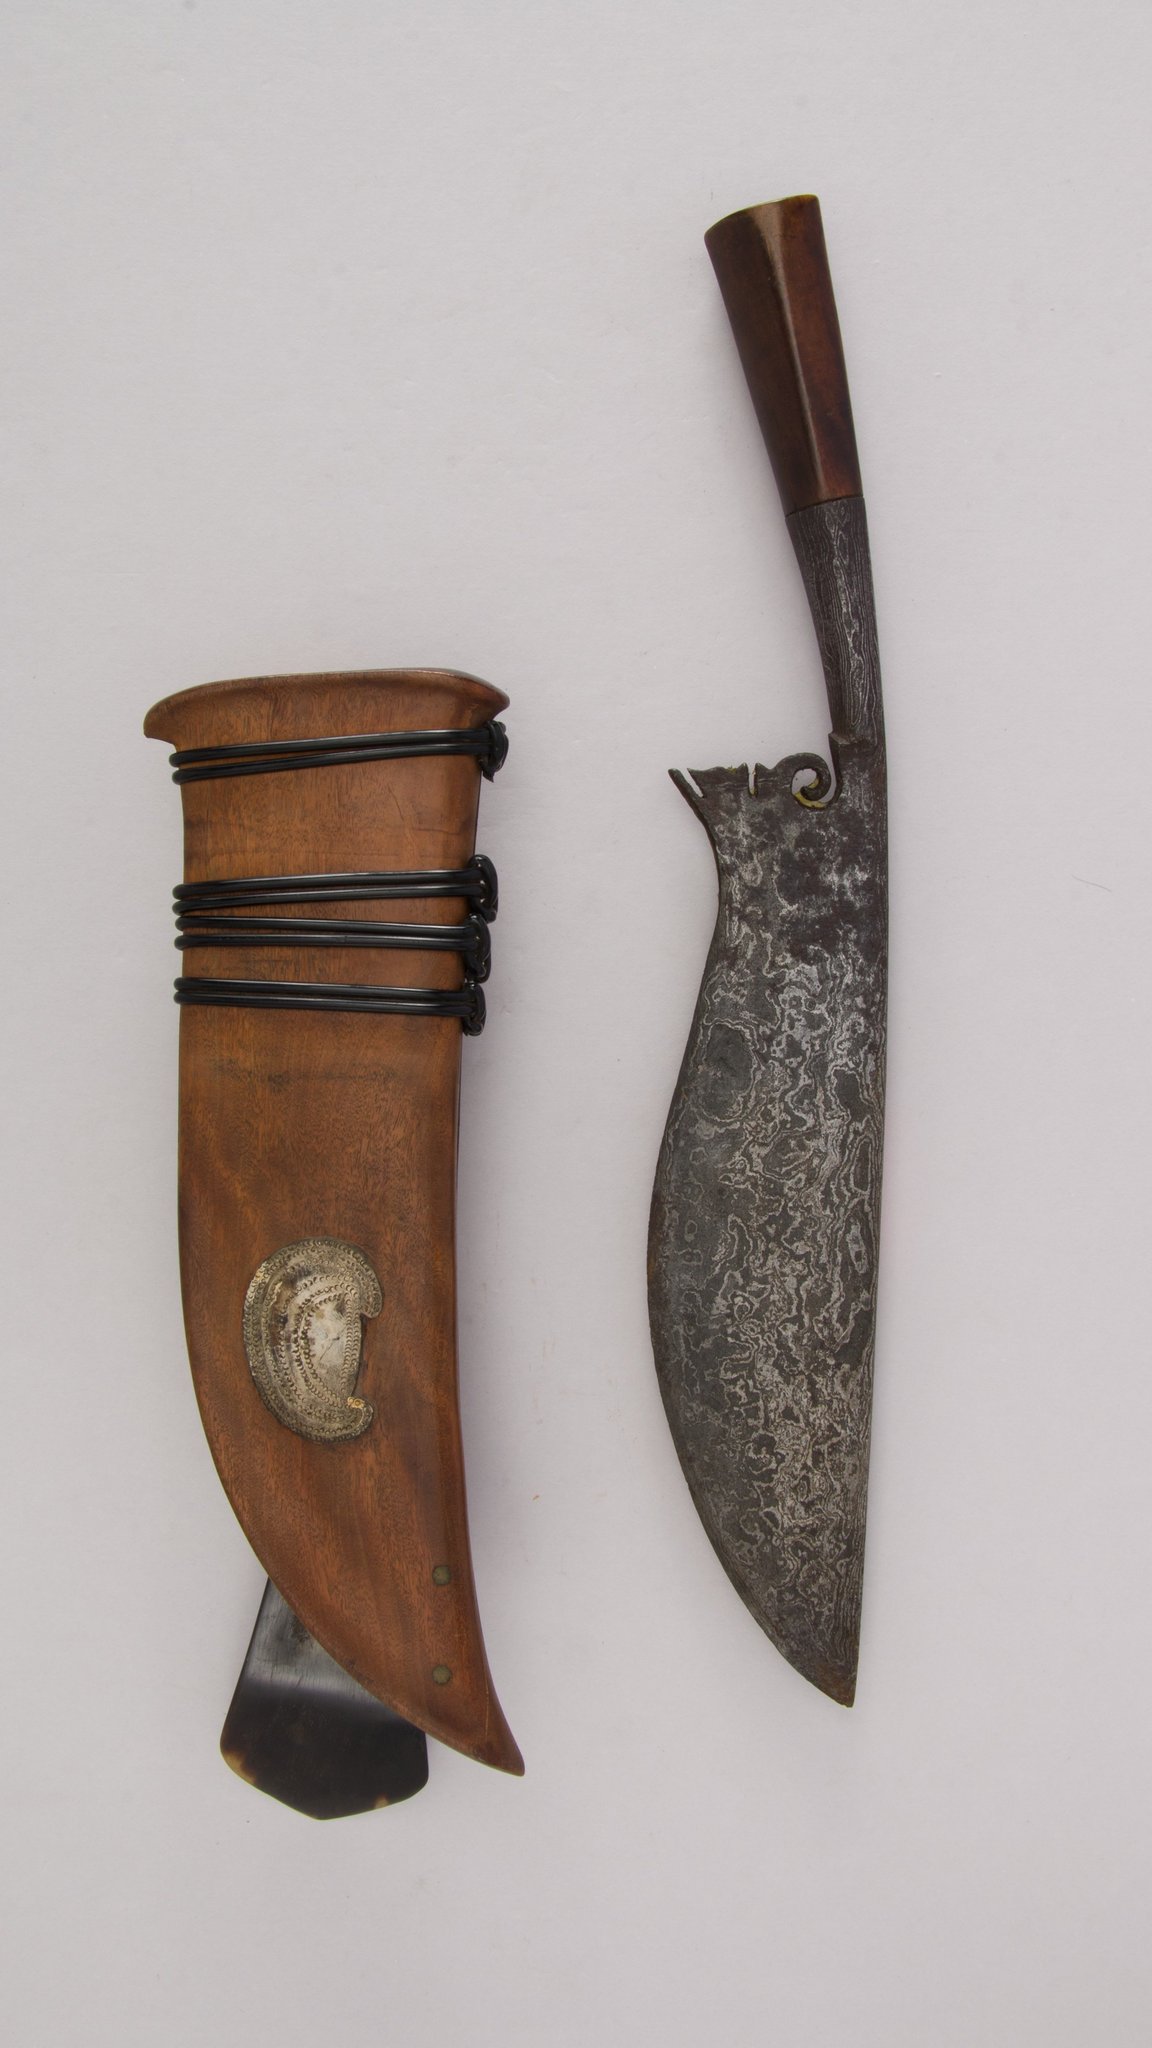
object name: knife with sheath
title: Knife (Wedong) with Sheath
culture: javanese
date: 1501-1900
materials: wood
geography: indonesia